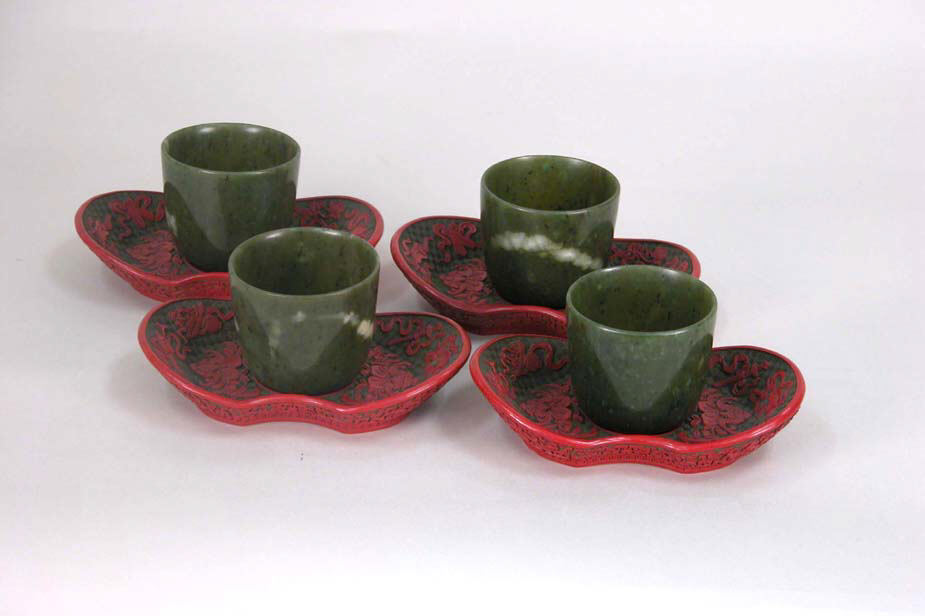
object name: cup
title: Set of Four Cups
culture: chinese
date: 1644-1911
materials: jade